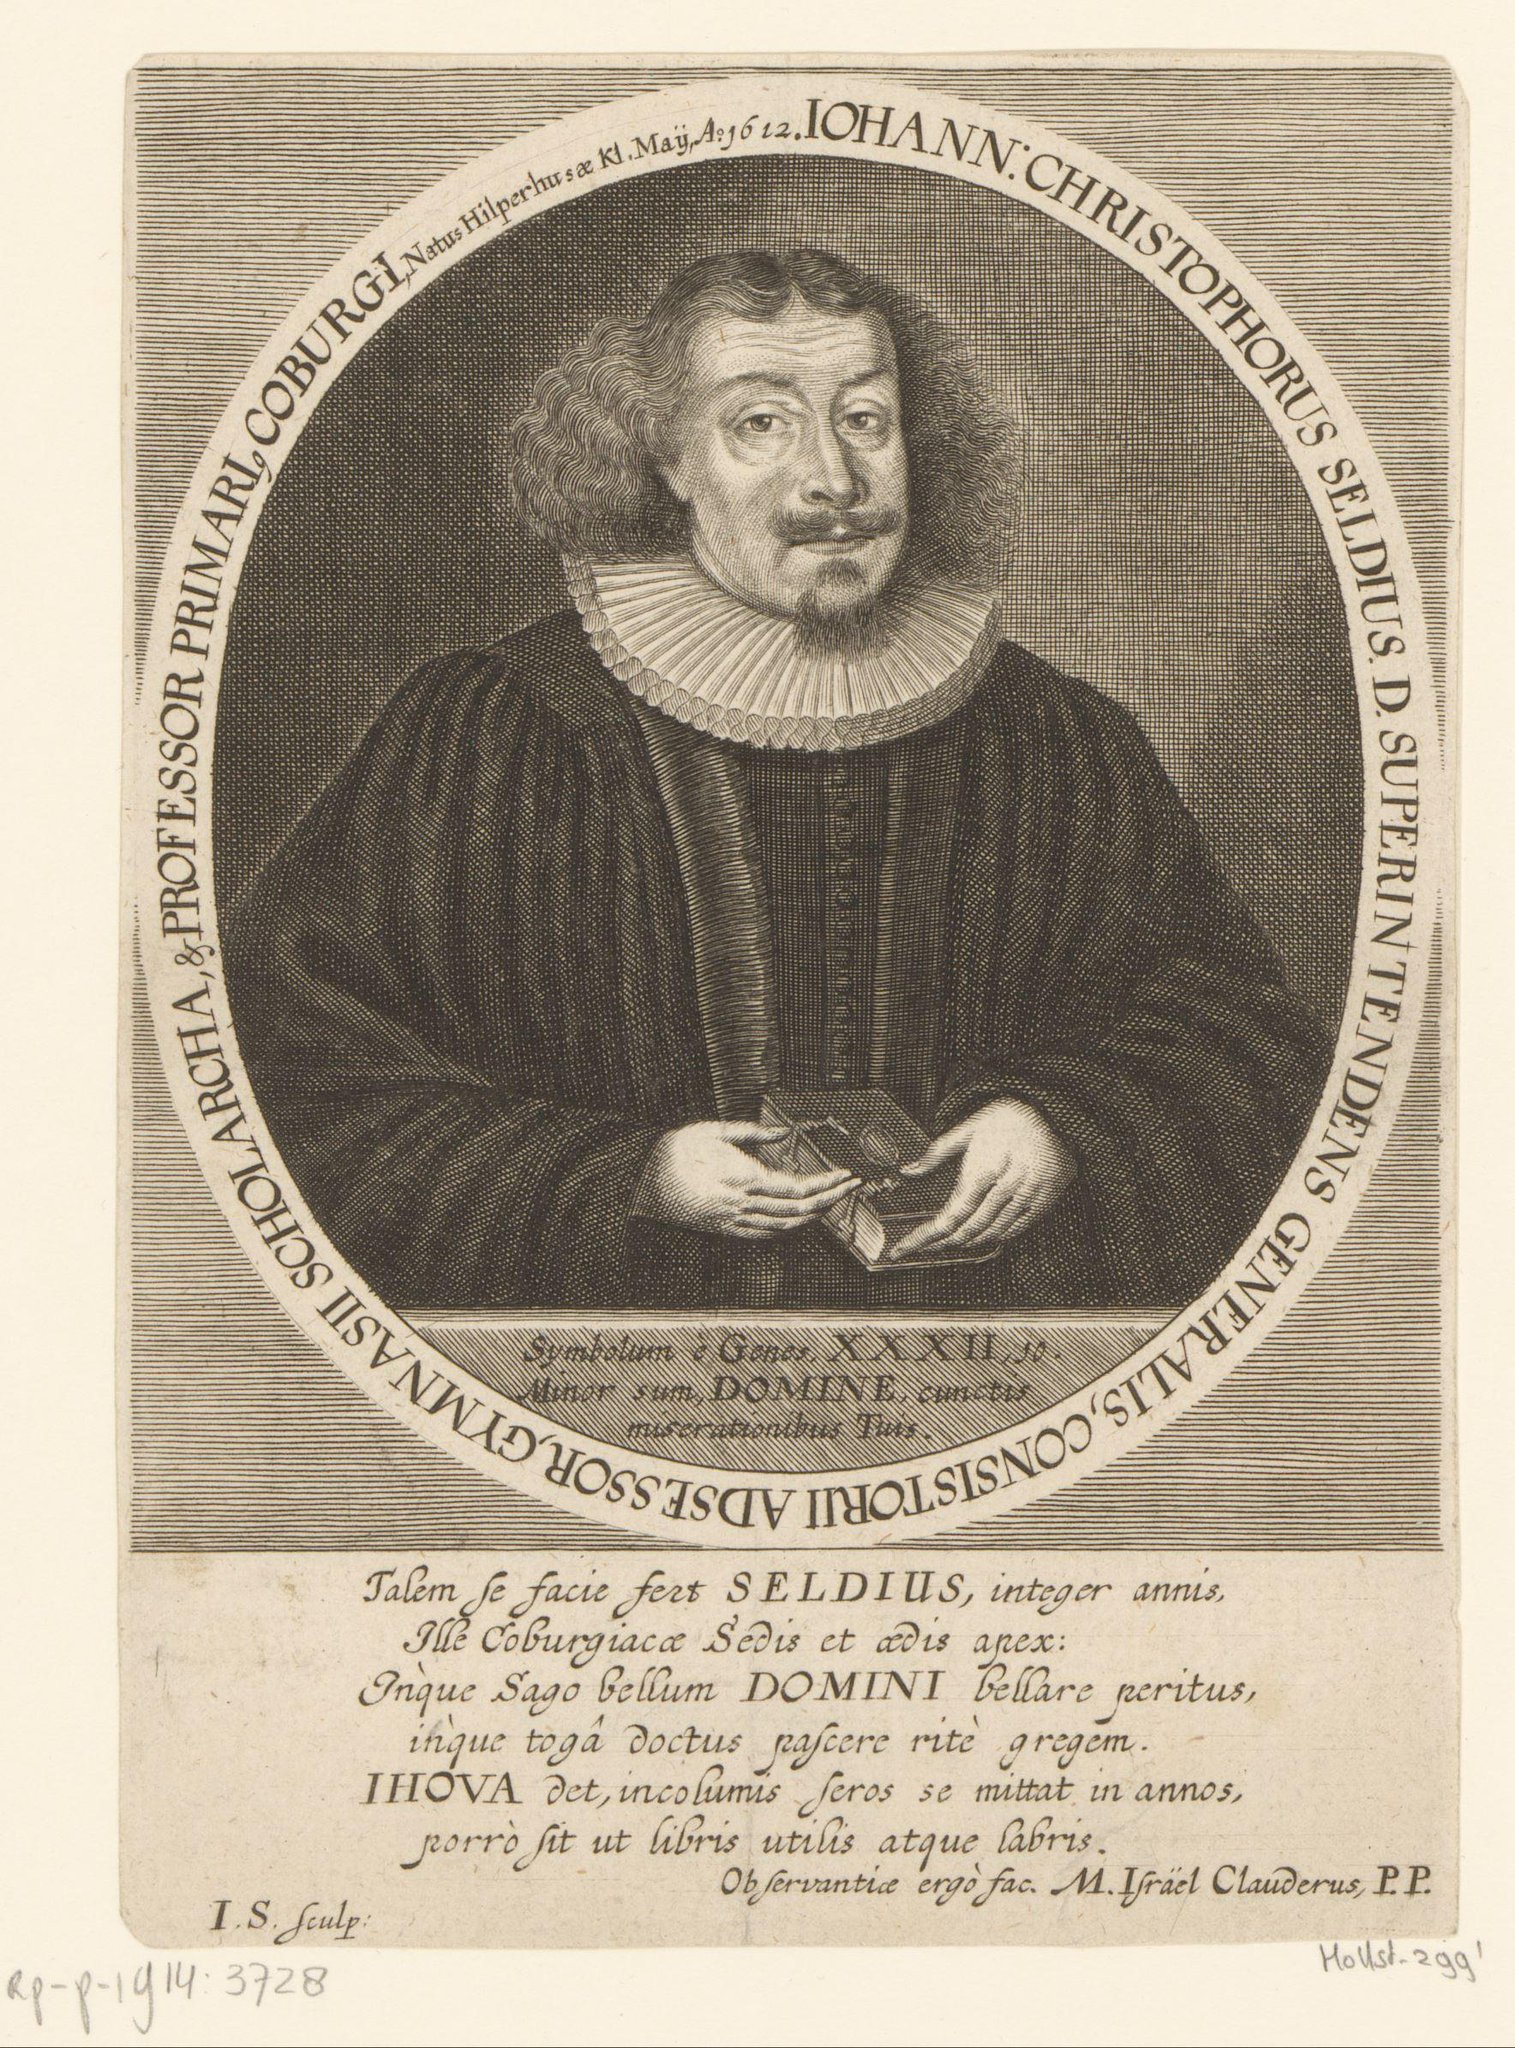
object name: print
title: Portret van Johann Christoph Seld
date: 1677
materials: paper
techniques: engraving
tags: johann christoph seld, historical persons, book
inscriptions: collector's mark: Lugt 2228